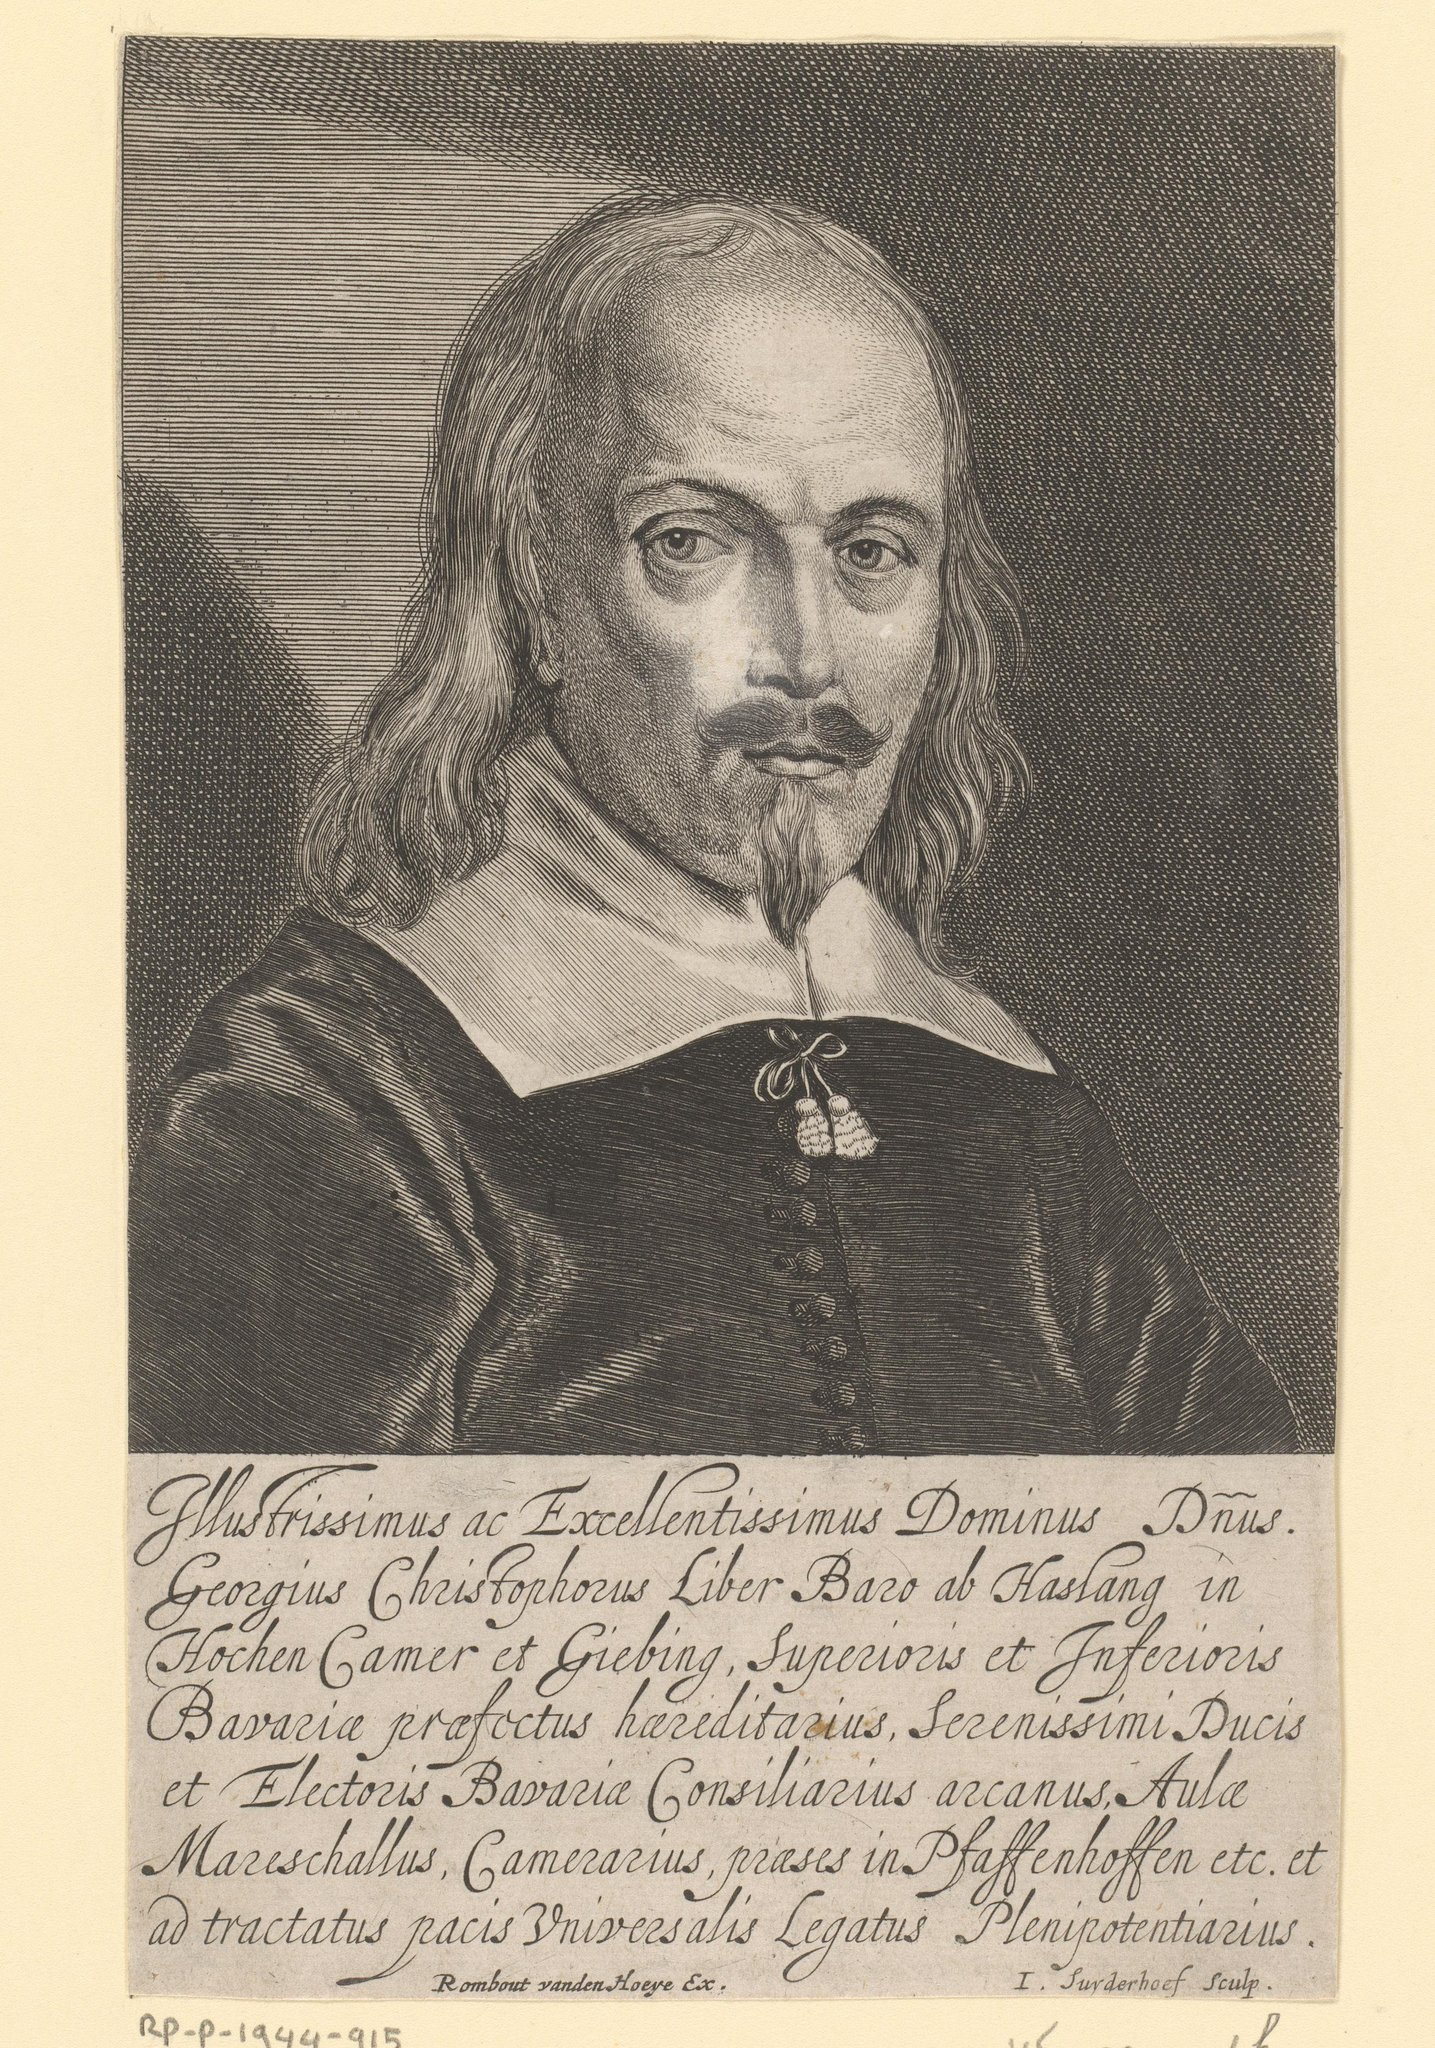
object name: print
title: Pacificatores orbis Christiani in Westphaliam missi anno 1641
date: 1644-1671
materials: paper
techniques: engraving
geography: amsterdam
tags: politician, historical persons, diplomacy, diplomat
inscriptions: inscription: ‘N10824 1,6’, collector's mark: Lugt 2228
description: Prent maakt deel uit van een serie van 43 prenten. Eerdere staat van prent gebruikt in de serie 'Icones legatorum Monasterii et Osnabrugae existentium', uitgegeven door Abraham van Waesbergen in Amsterdam.